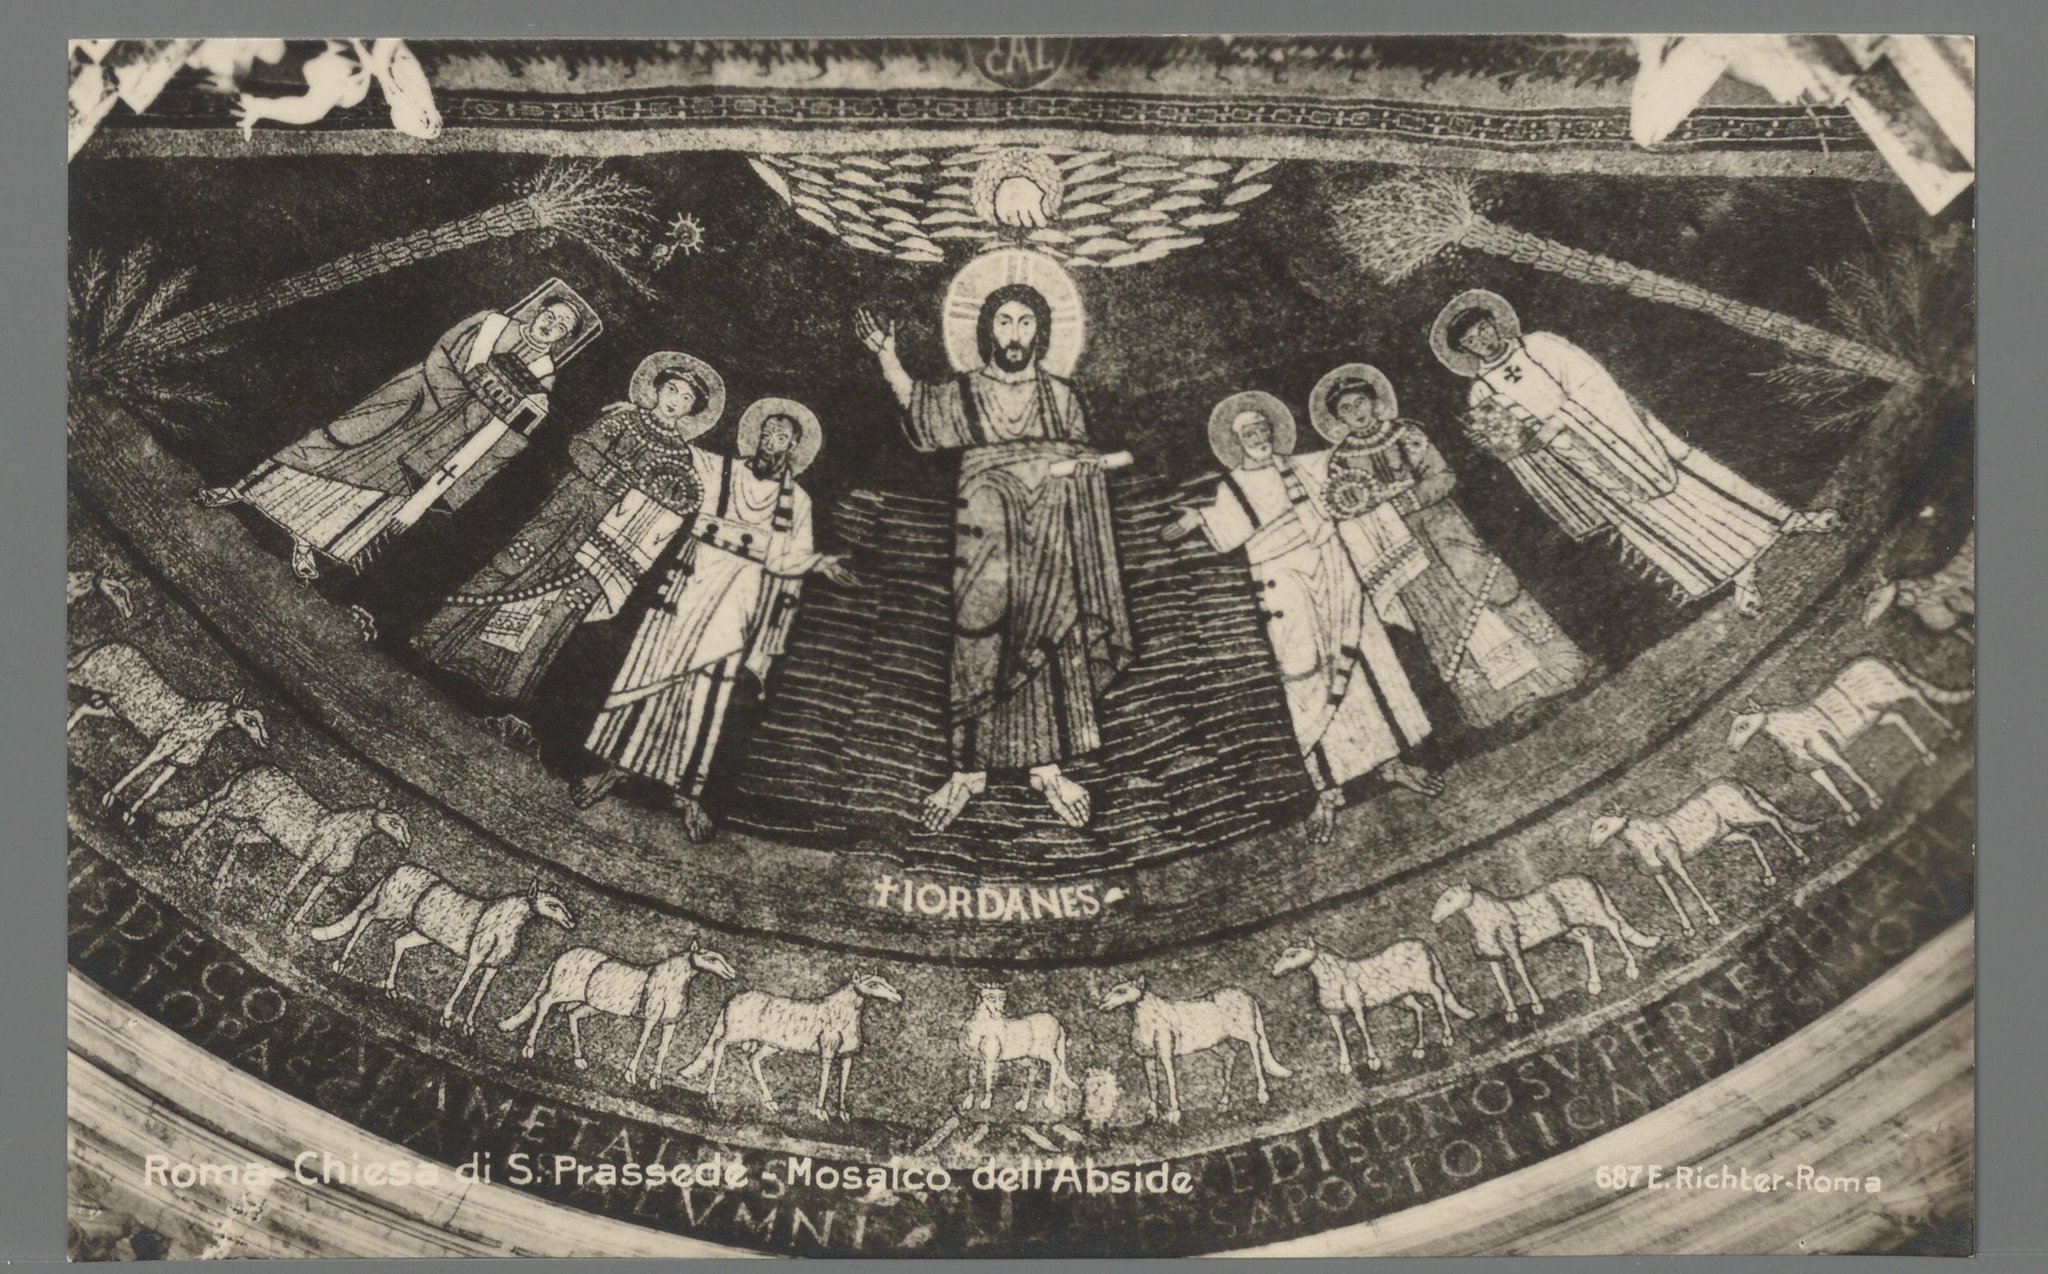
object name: ansichtkaart, prentbriefkaart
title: Roma - Chiesa di S. Prassede - Mosaico dell'Abside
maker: ernesto richter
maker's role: publisher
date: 1906-1930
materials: paper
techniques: gelatin silver print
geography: rome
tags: interior of church, (decorated) ceiling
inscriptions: collector's mark: ‘AFE v S’